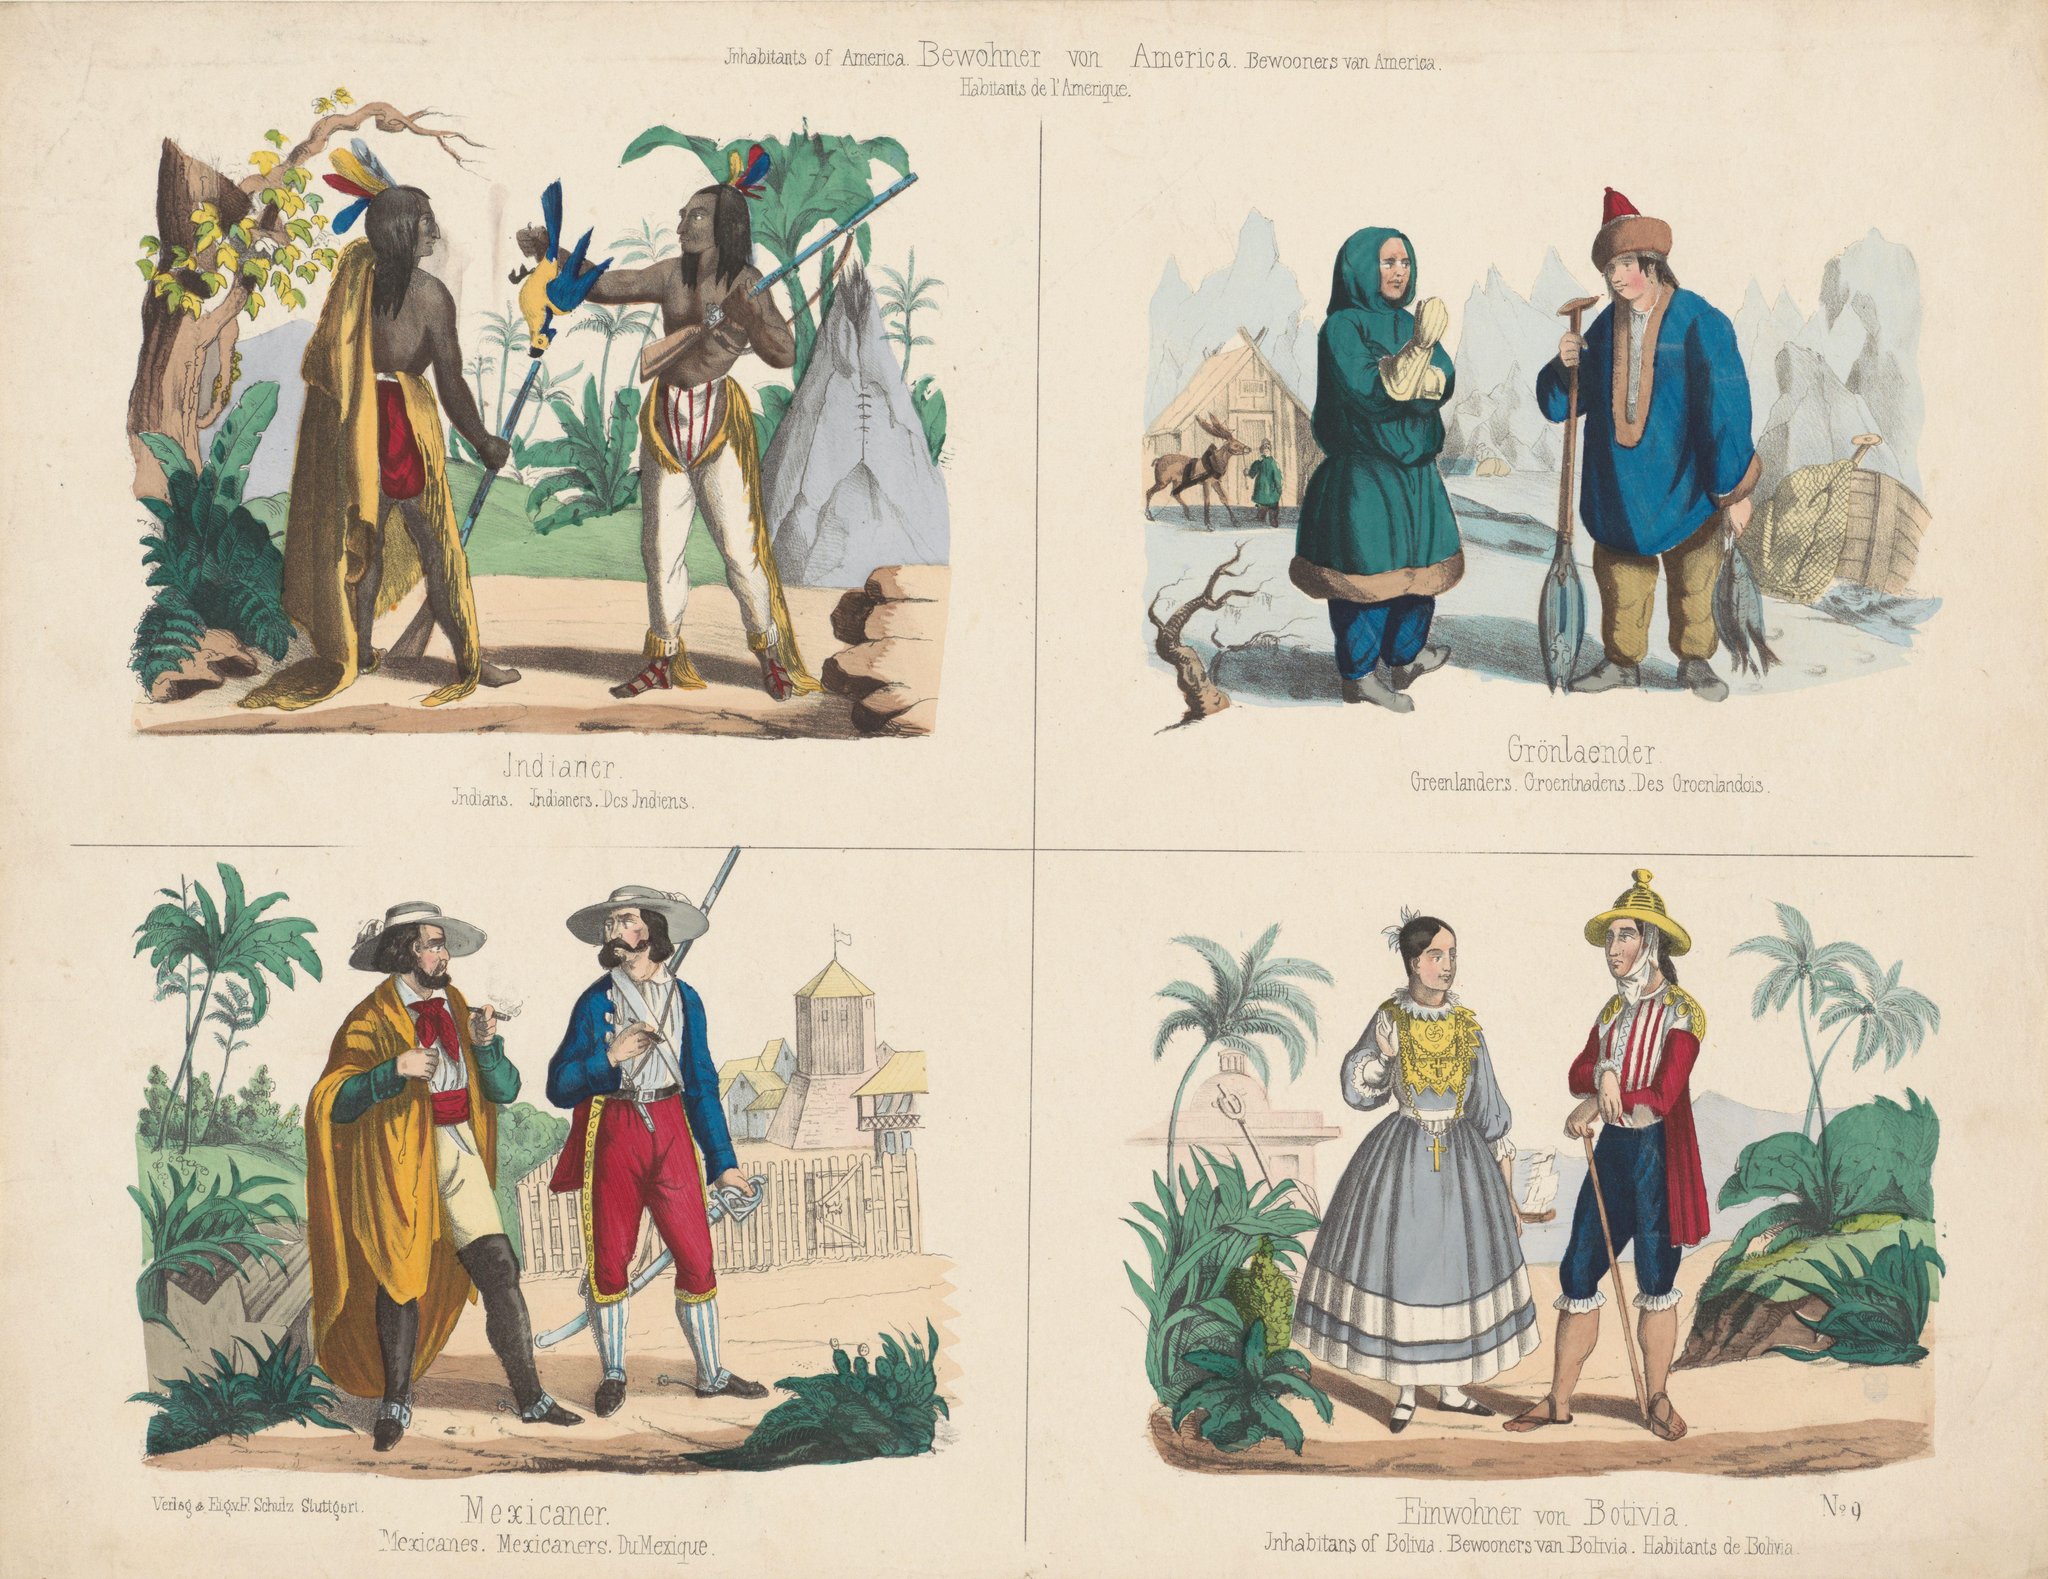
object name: popular print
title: Inhabitants of America. / Bewohner von America. / Bewooners van America. / Habitants de l'Amerique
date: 1820-1865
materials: paper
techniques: colour, lithograph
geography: stuttgart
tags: indigenous peoples of the american arctic regions, indigenous peoples of the arctic regions: inuit, indigenous peoples of north america, indigenous peoples of south america, greenland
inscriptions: collector's mark: Lugt 2760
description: Blad met vier voorstellingen van paren van verschillende Amerikaanse volkeren, waaronder oorspronkelijke Noord-Amerikanen, Groenlanders, Mexicanen en Bolivianen. Onder elke afbeelding een onderschrift in vier talen. Genummerd rechtsonder: No. 9.